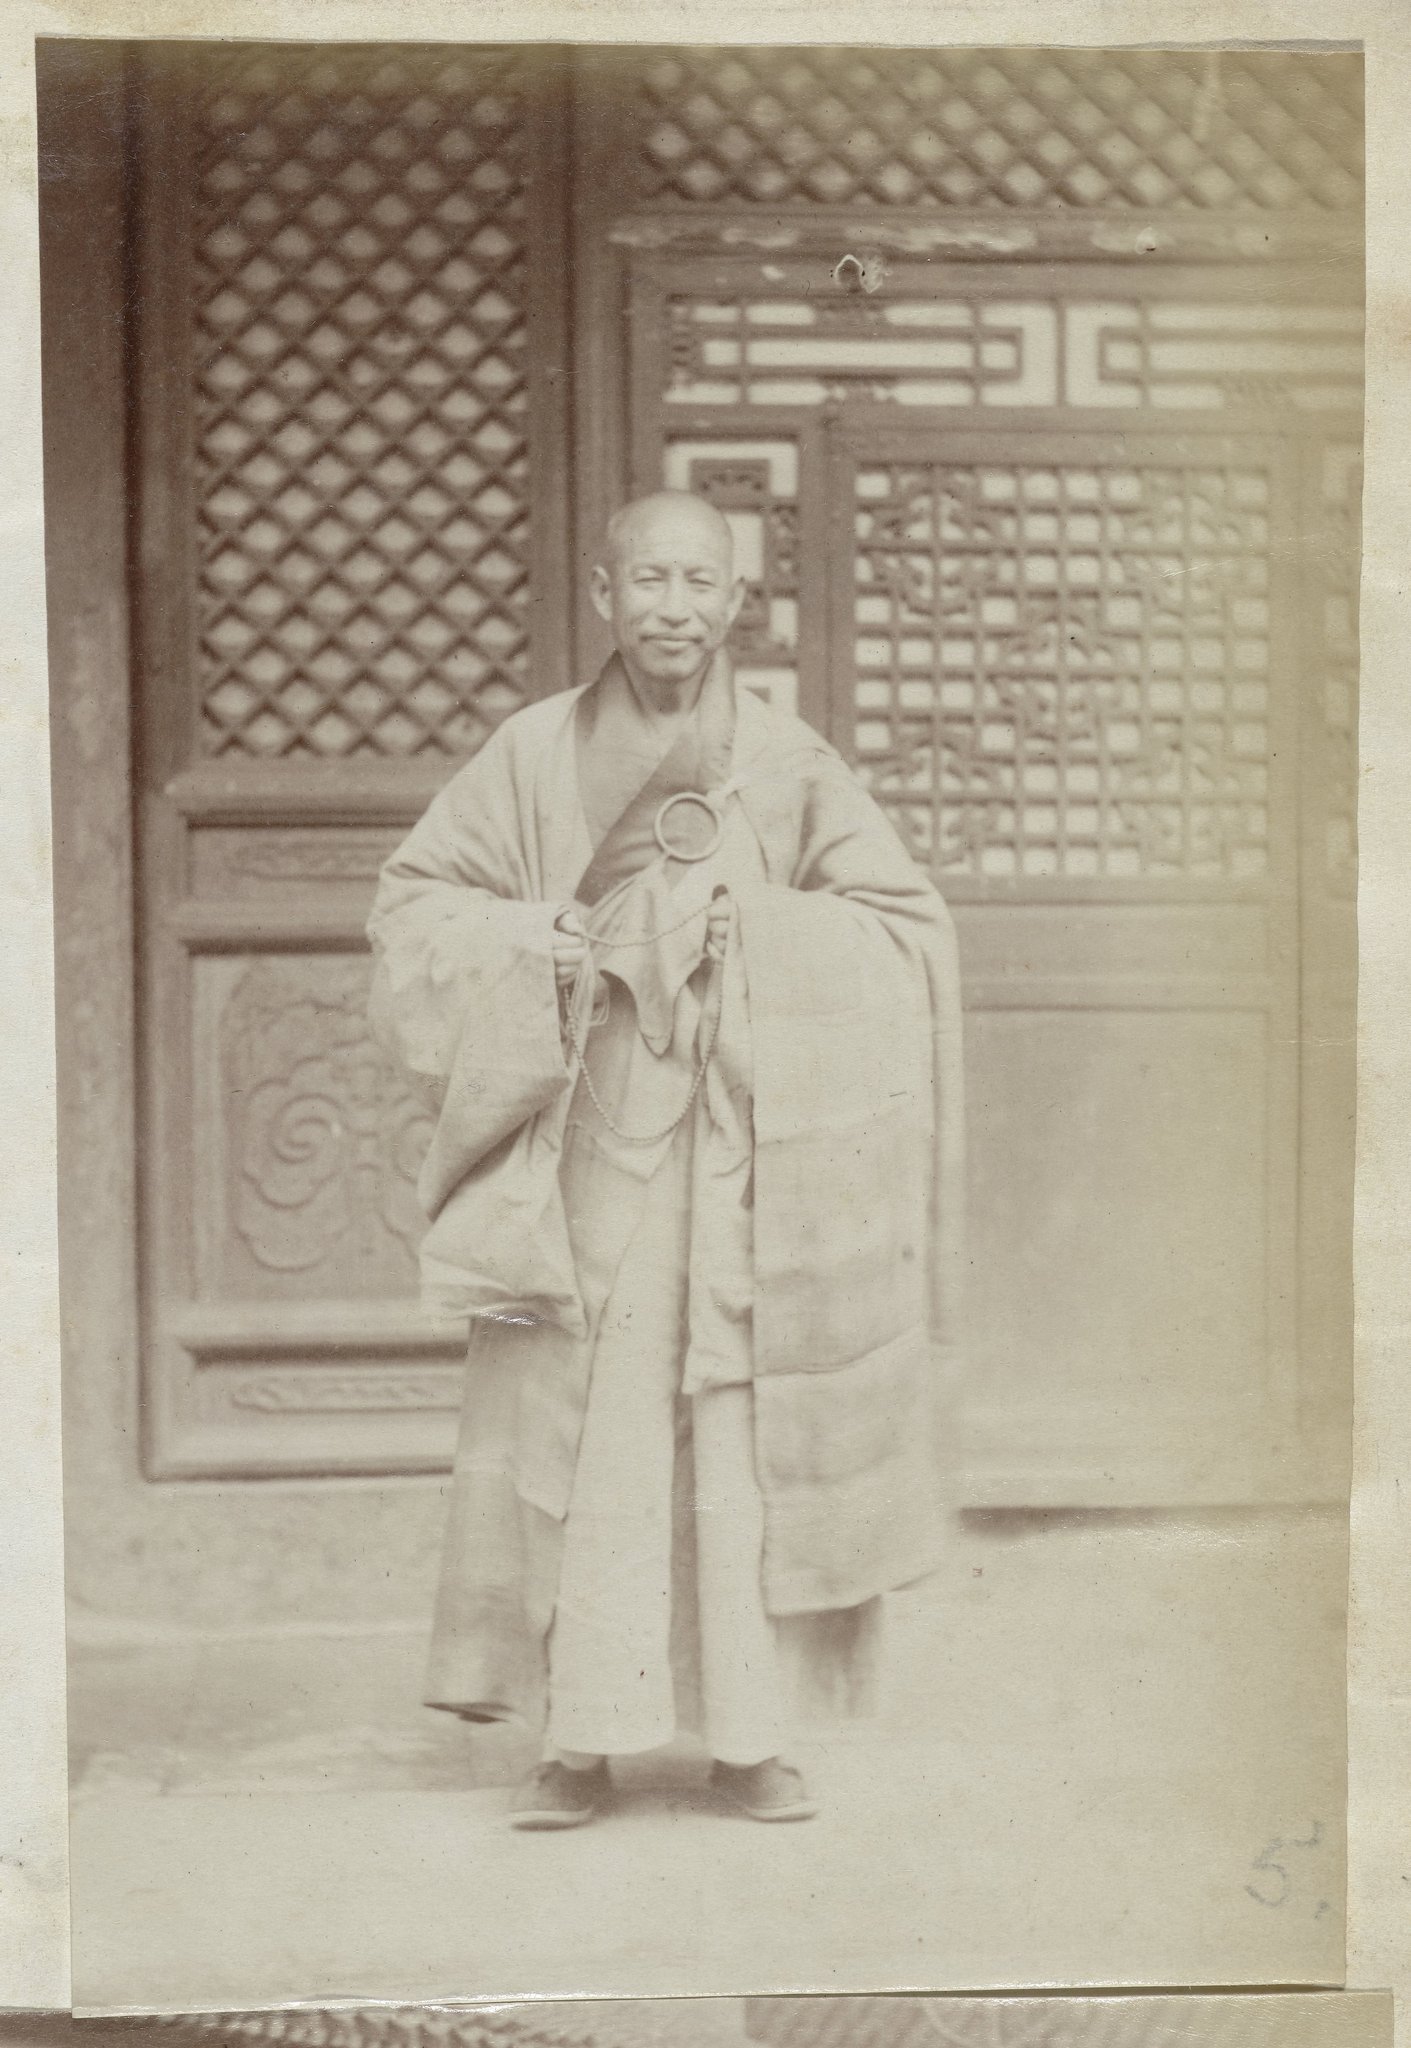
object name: photograph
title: Portret van een boeddhistische monnik in China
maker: Anonymous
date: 1879-1890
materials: paper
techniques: albumen print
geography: china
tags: religious functionaries ~ hinduism, buddhism, jainism, historical persons not known by name, china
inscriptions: number: ‘5.’